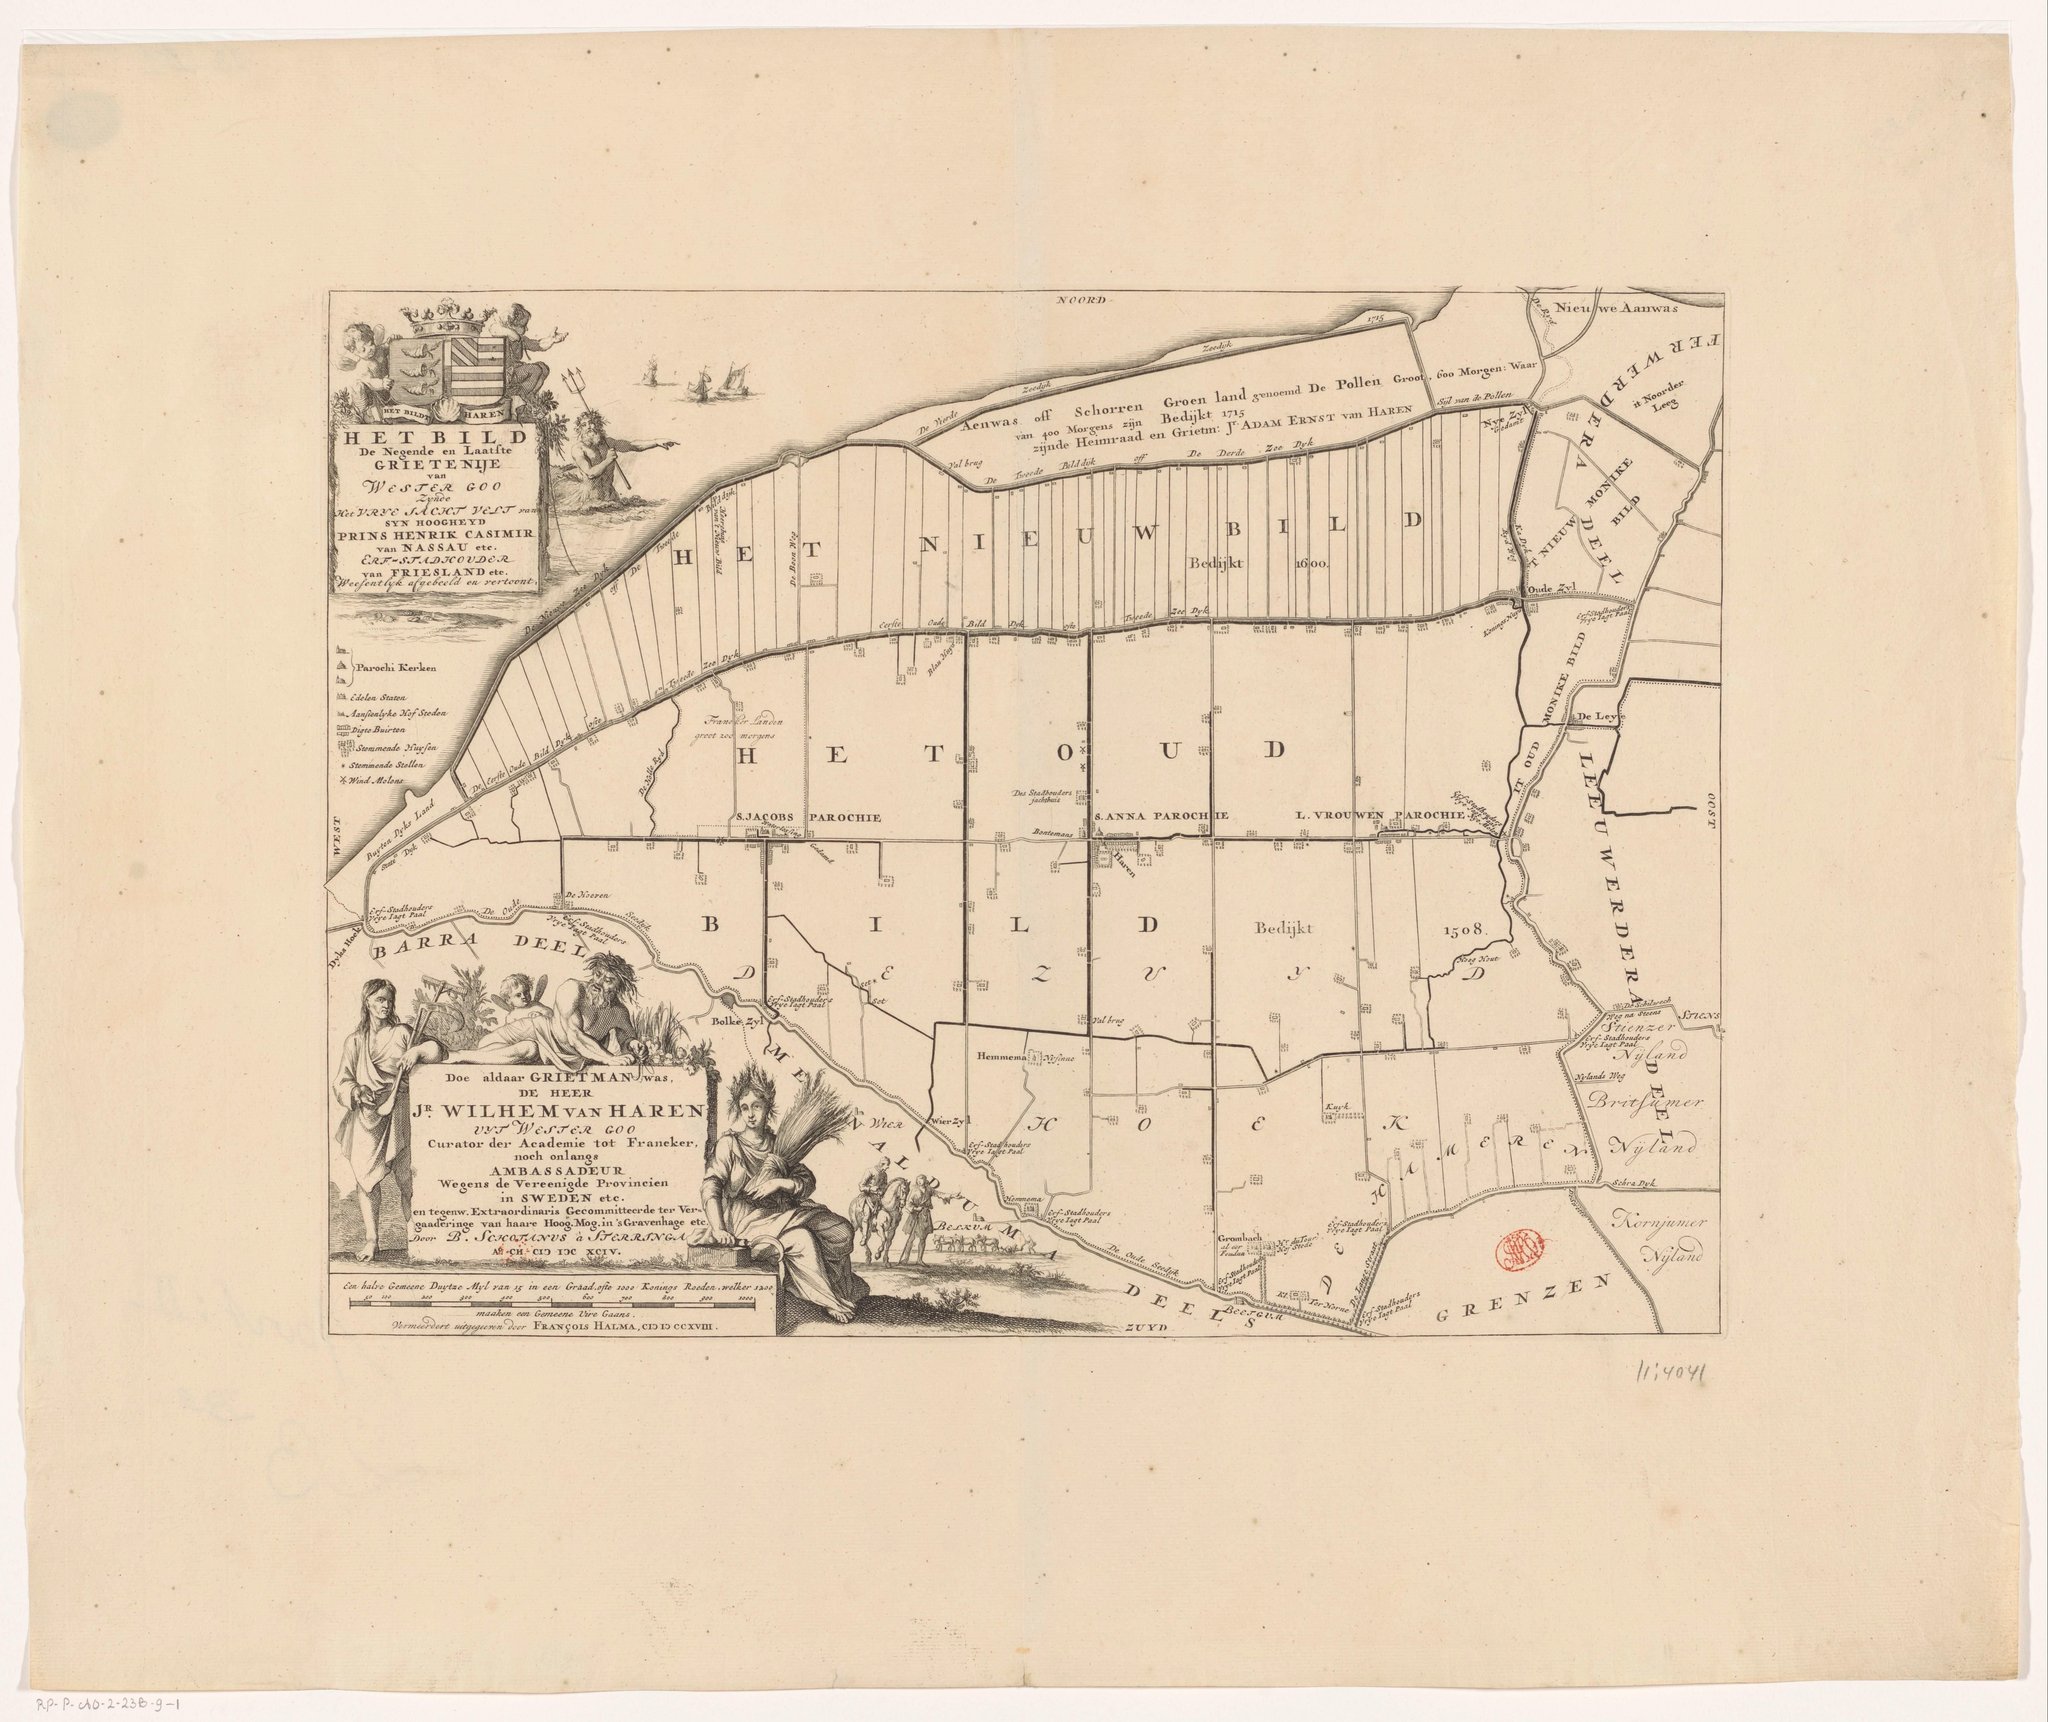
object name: map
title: Het Bild de negende en laatste grietenije van Wester goo (...)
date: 1698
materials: paper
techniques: engraving, etching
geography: leeuwarden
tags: coat of arms (as symbol of the state, etc.), (story of) ceres (demeter), triton(s), maps of separate countries or regions, river-gods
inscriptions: collector's mark: Lugt 2228, label: ‘264’, collector's mark: Lugt 195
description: Linksboven titelcartouche met daaromheen de wapens van Het Bildt en van grietman jonker Willem van Haren, putti en een triton. Daaronder legenda. Linksonder cartouche met bestuurlijke informatie over de grietenij, daaromheen een landbouwer, een putto, een watergod en Ceres. Daaronder een schaalstok: Een halve Gemeene Duytze myl van 15 in een graad, ofte 1000 konings roeden, welker 1200 maaken een gemeene uire gaans.